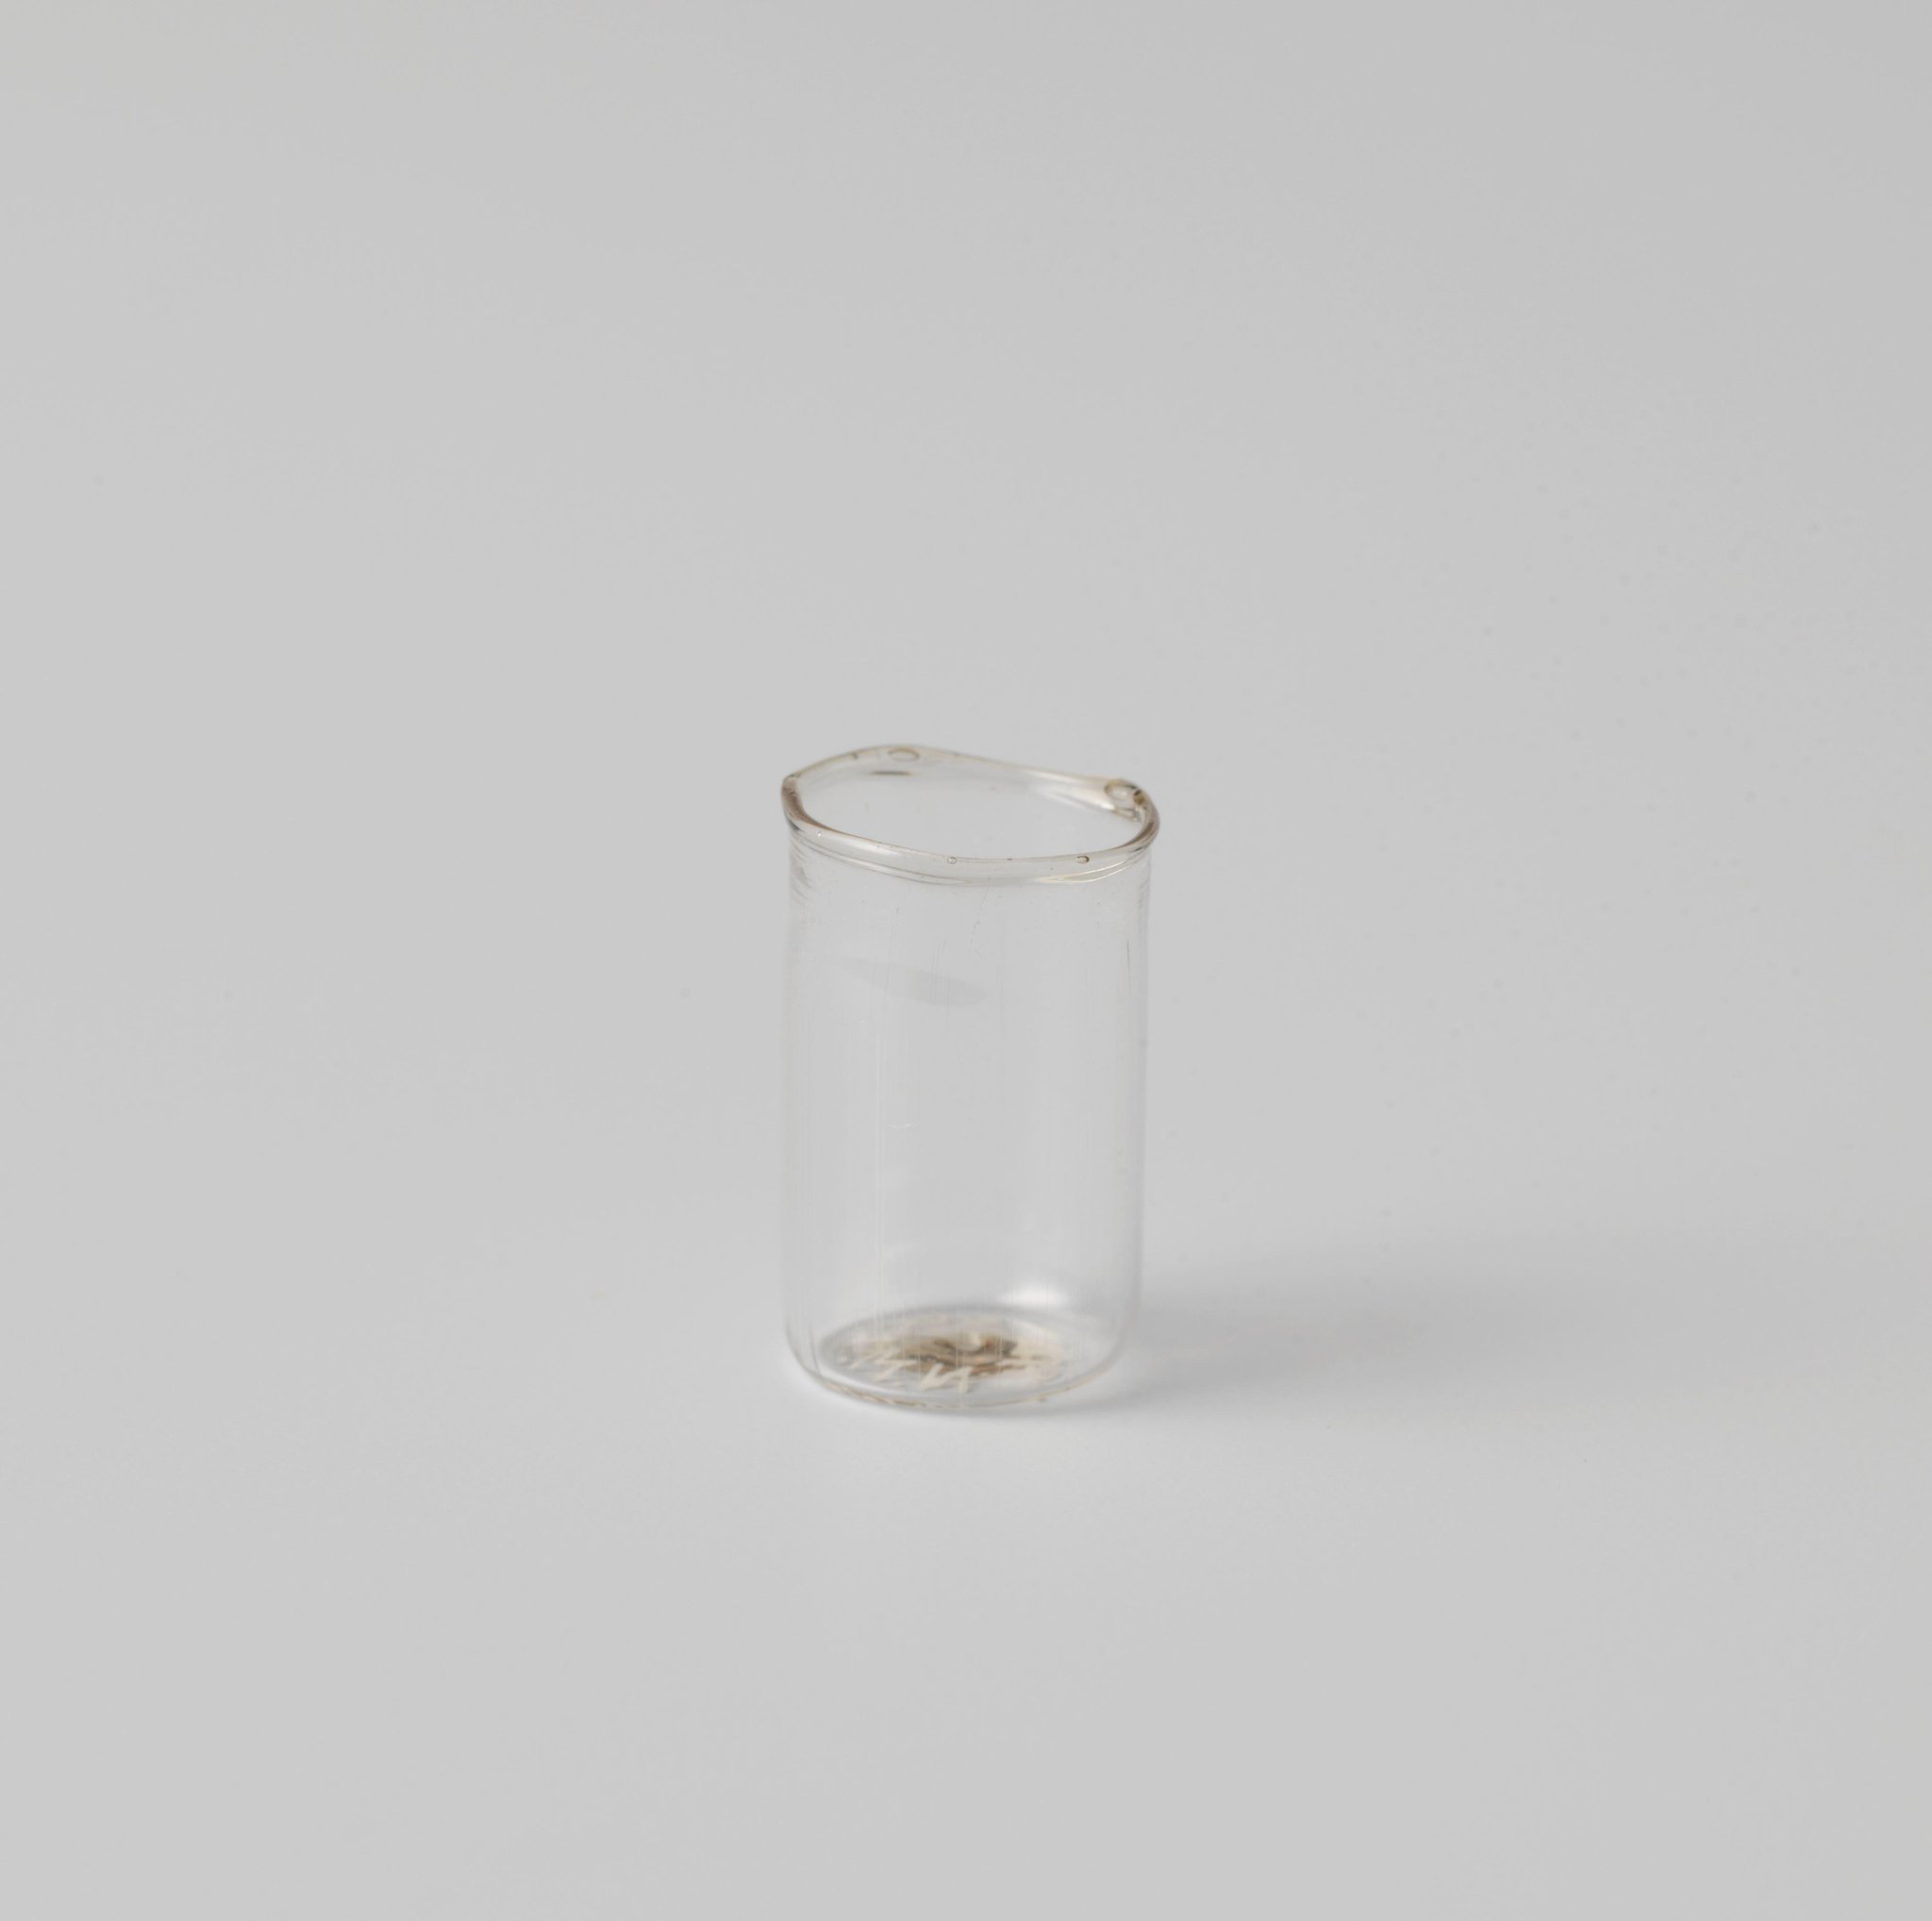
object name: miniature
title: Beker, cilindrisch, met vlakke bodem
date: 1675-1699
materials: glass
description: Een cilindrische beker van helder kleurloos glas met vlakke bodem.